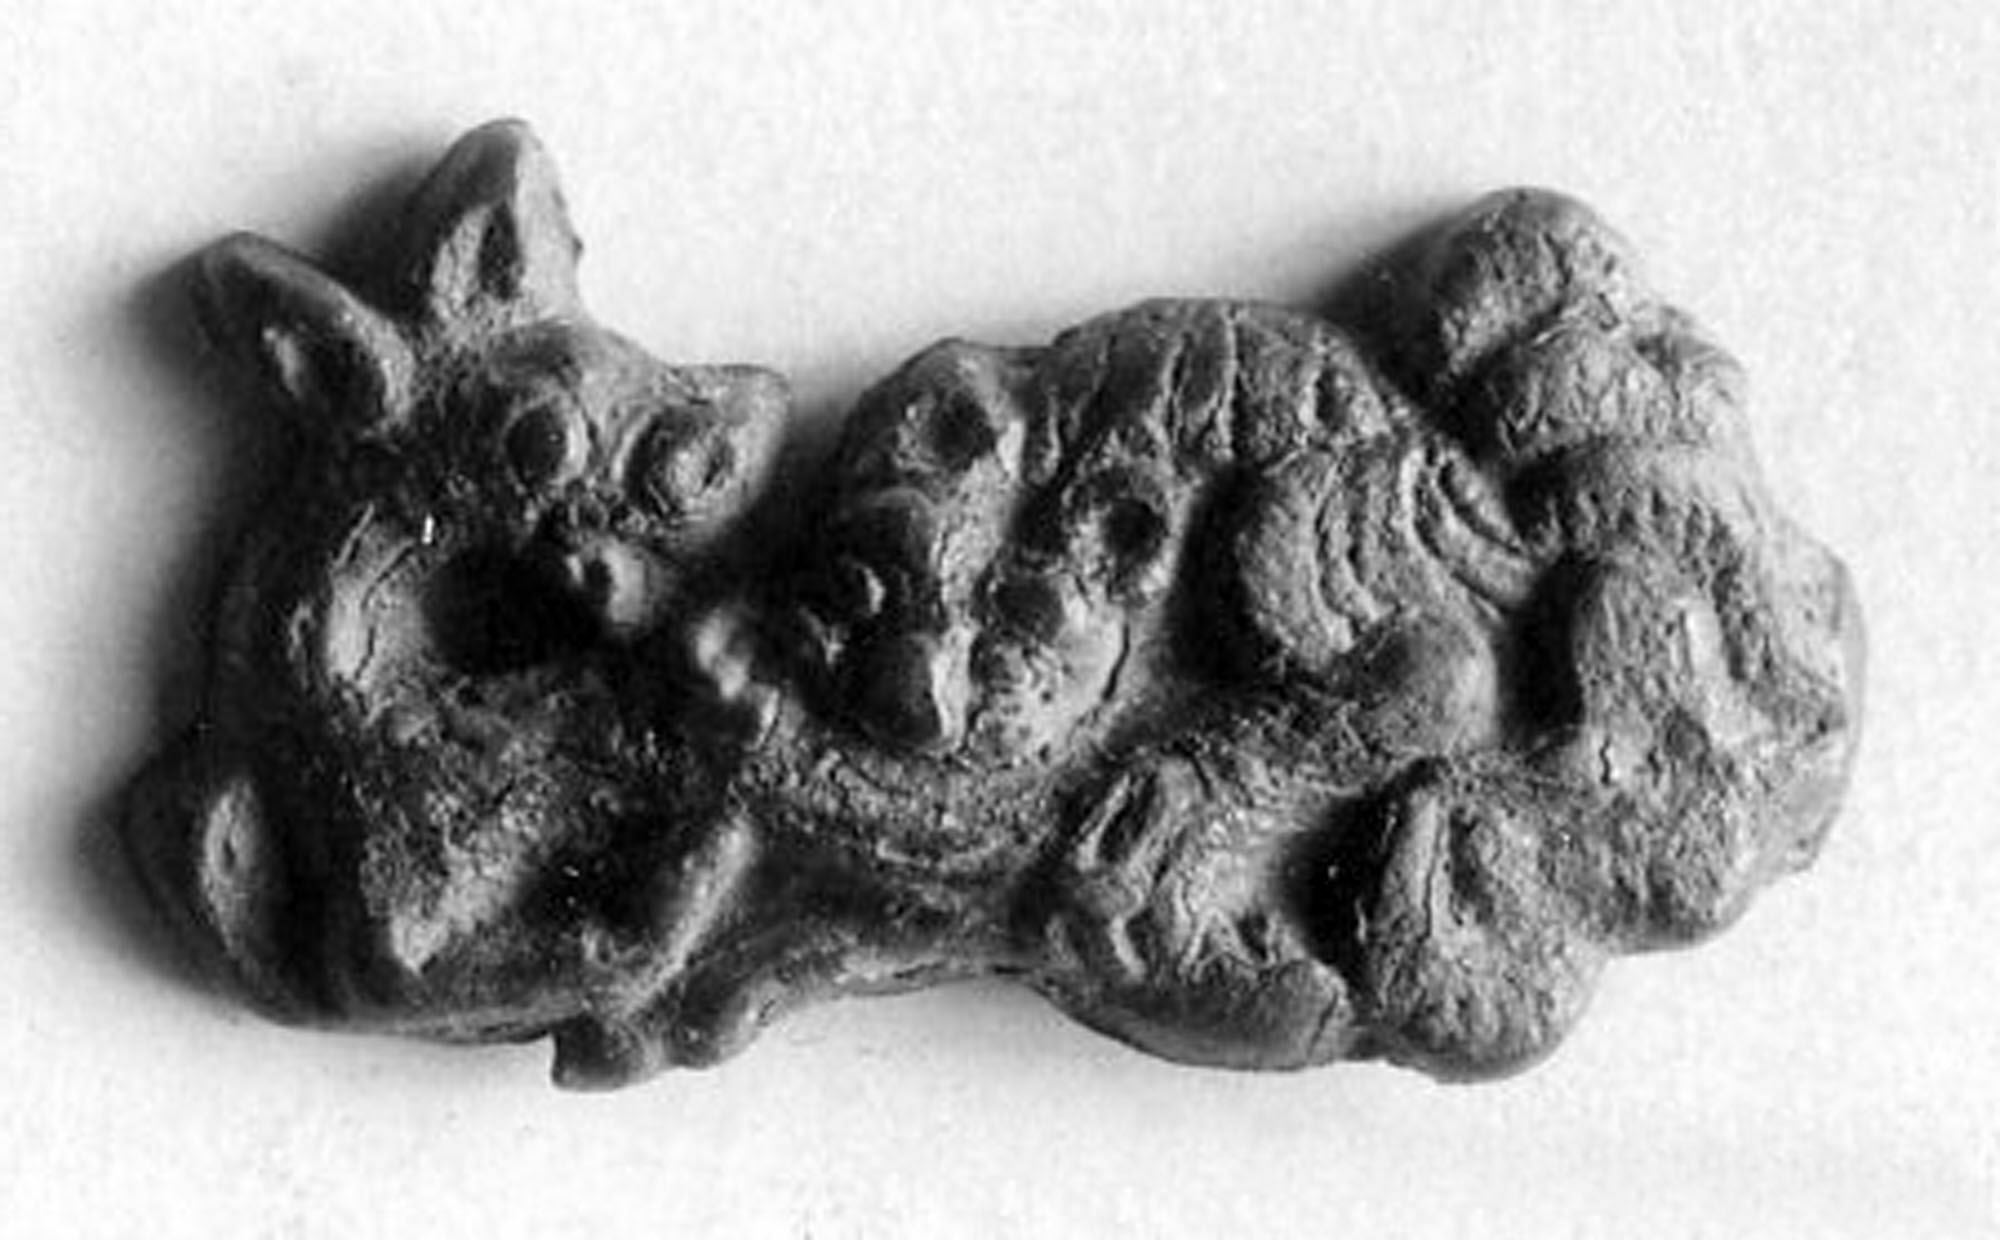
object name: belt plaque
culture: chinese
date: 201-600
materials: bronze